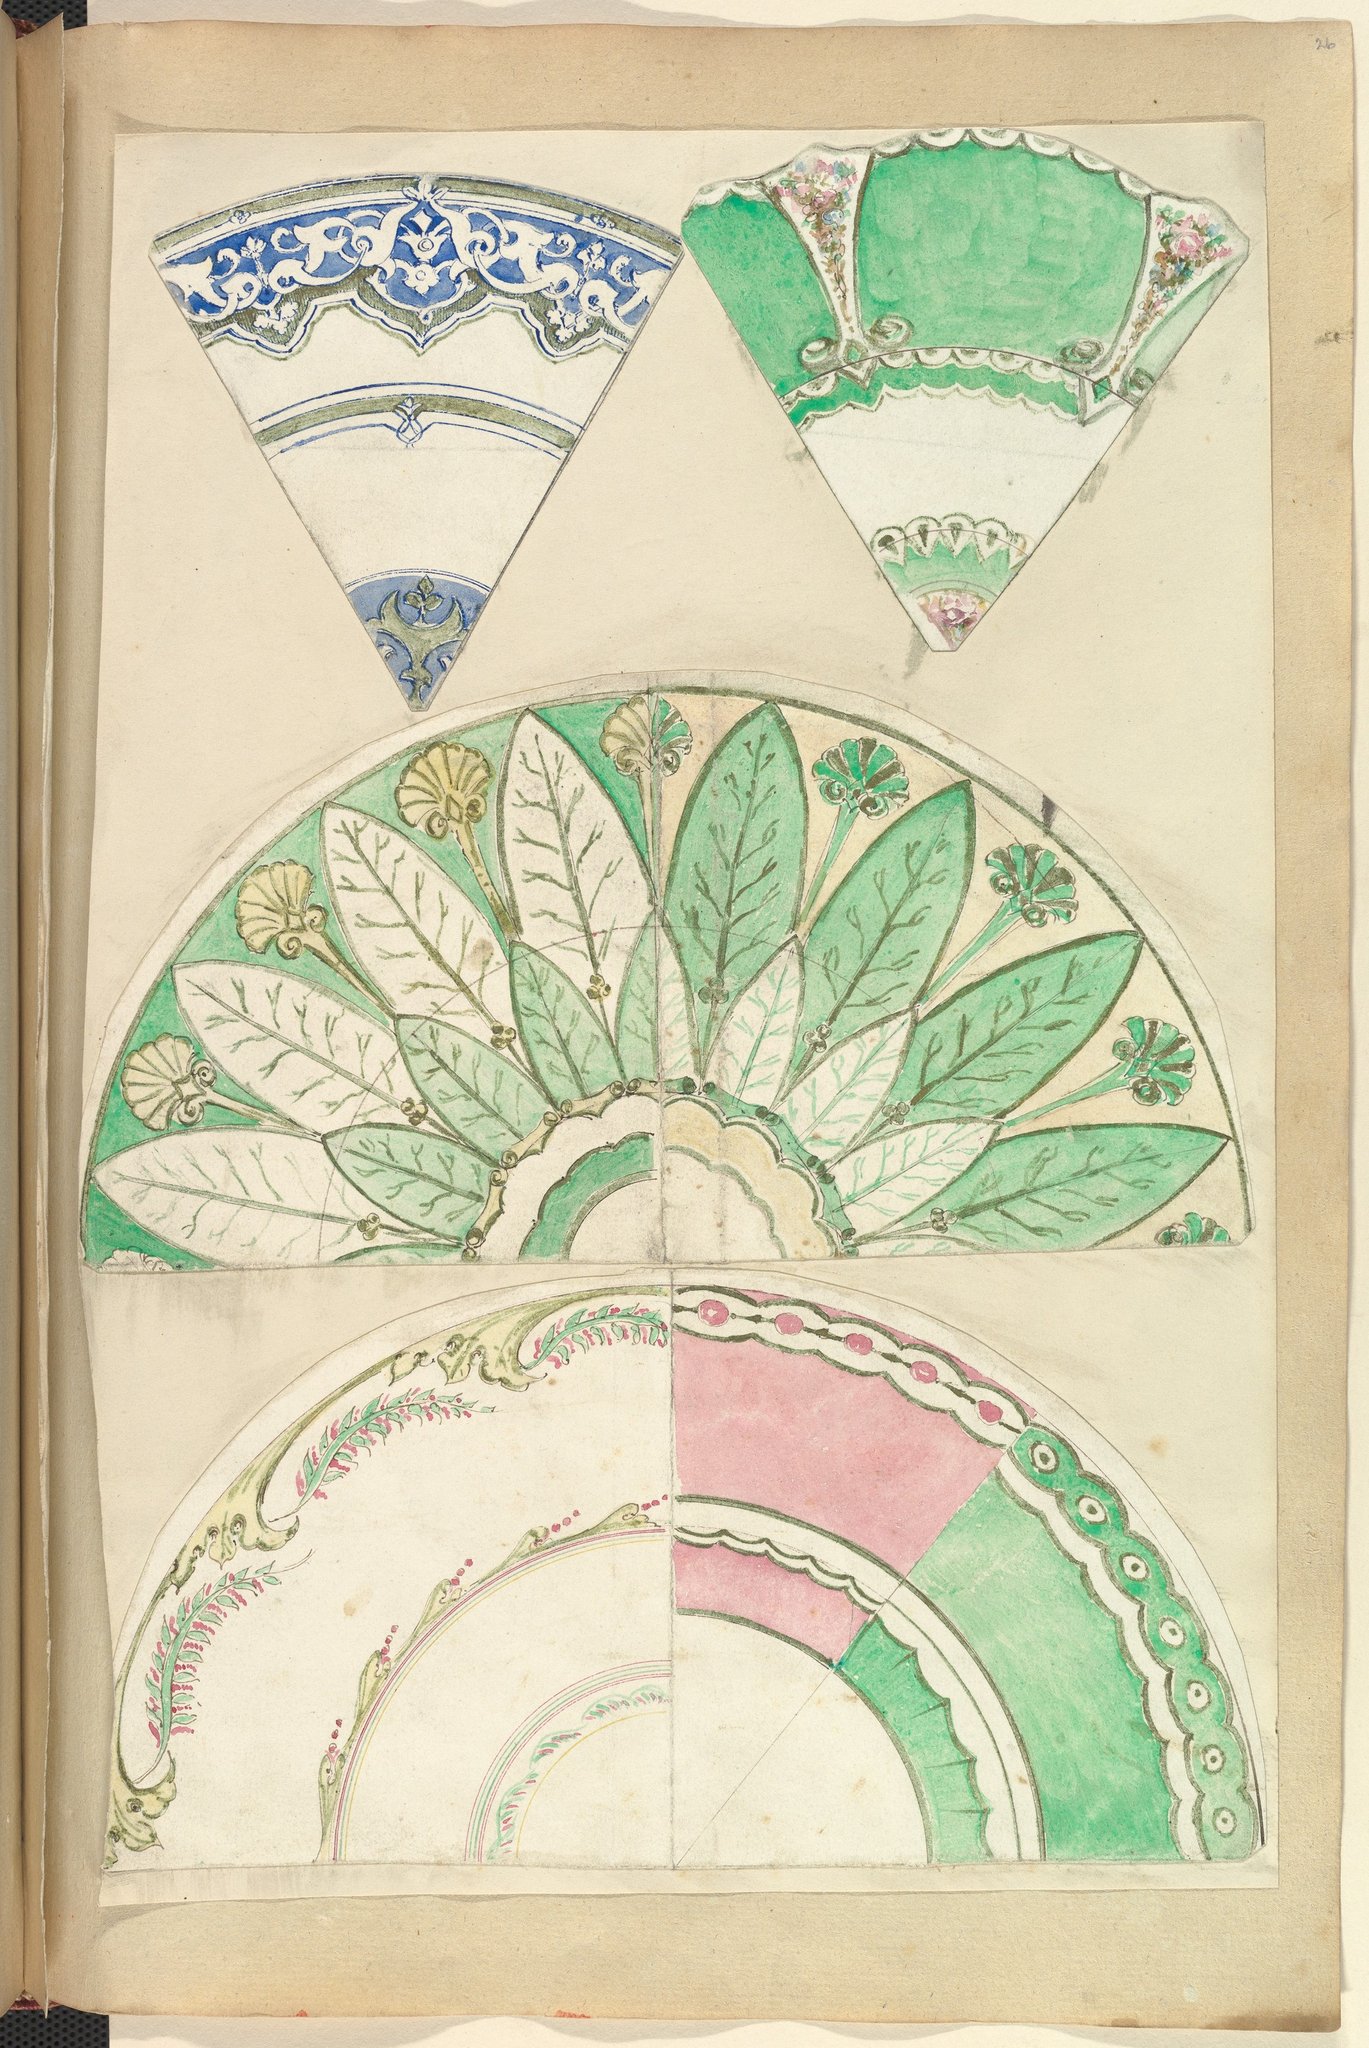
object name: drawing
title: Seven Designs for Decorated Plates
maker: alfred henry forrester [alfred crowquill]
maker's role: artist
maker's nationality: british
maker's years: 1804-1872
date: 1845-1855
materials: ink, watercolor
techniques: pen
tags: leaves